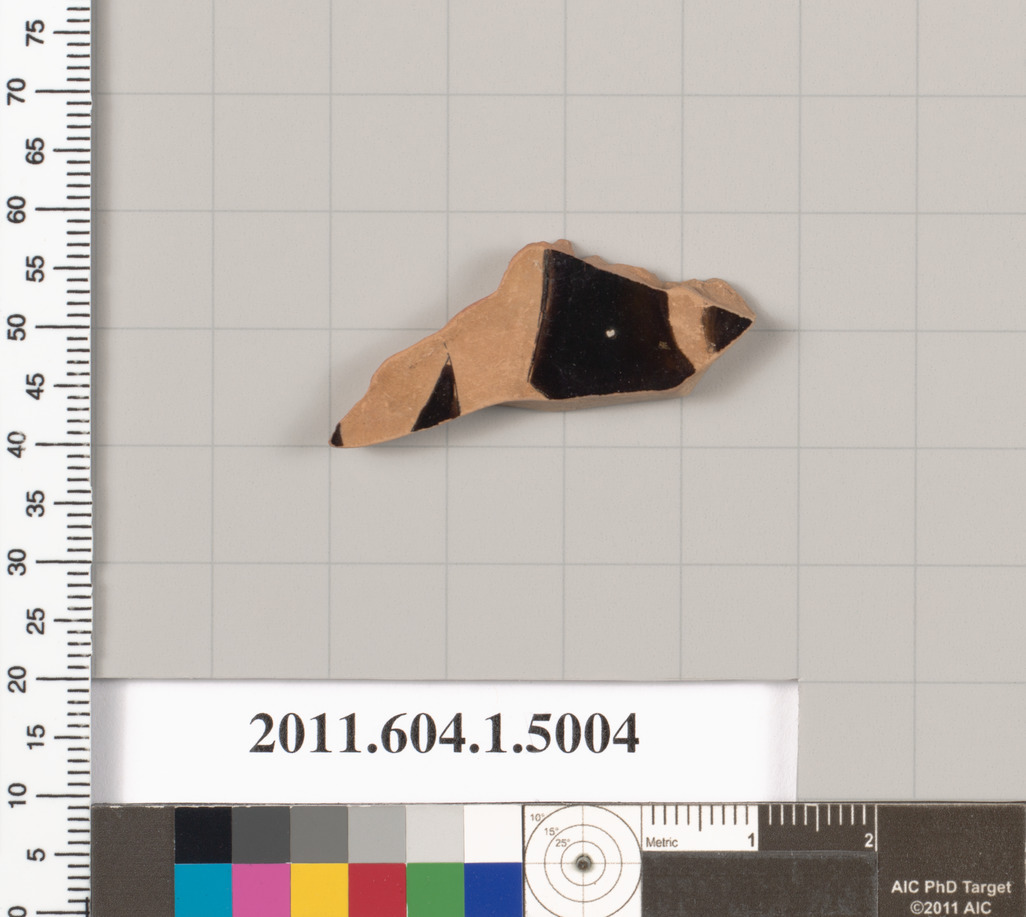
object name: kylix fragment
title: Terracotta fragment of a kylix (drinking cup)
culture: greek, attic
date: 500-480 BCE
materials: terracotta